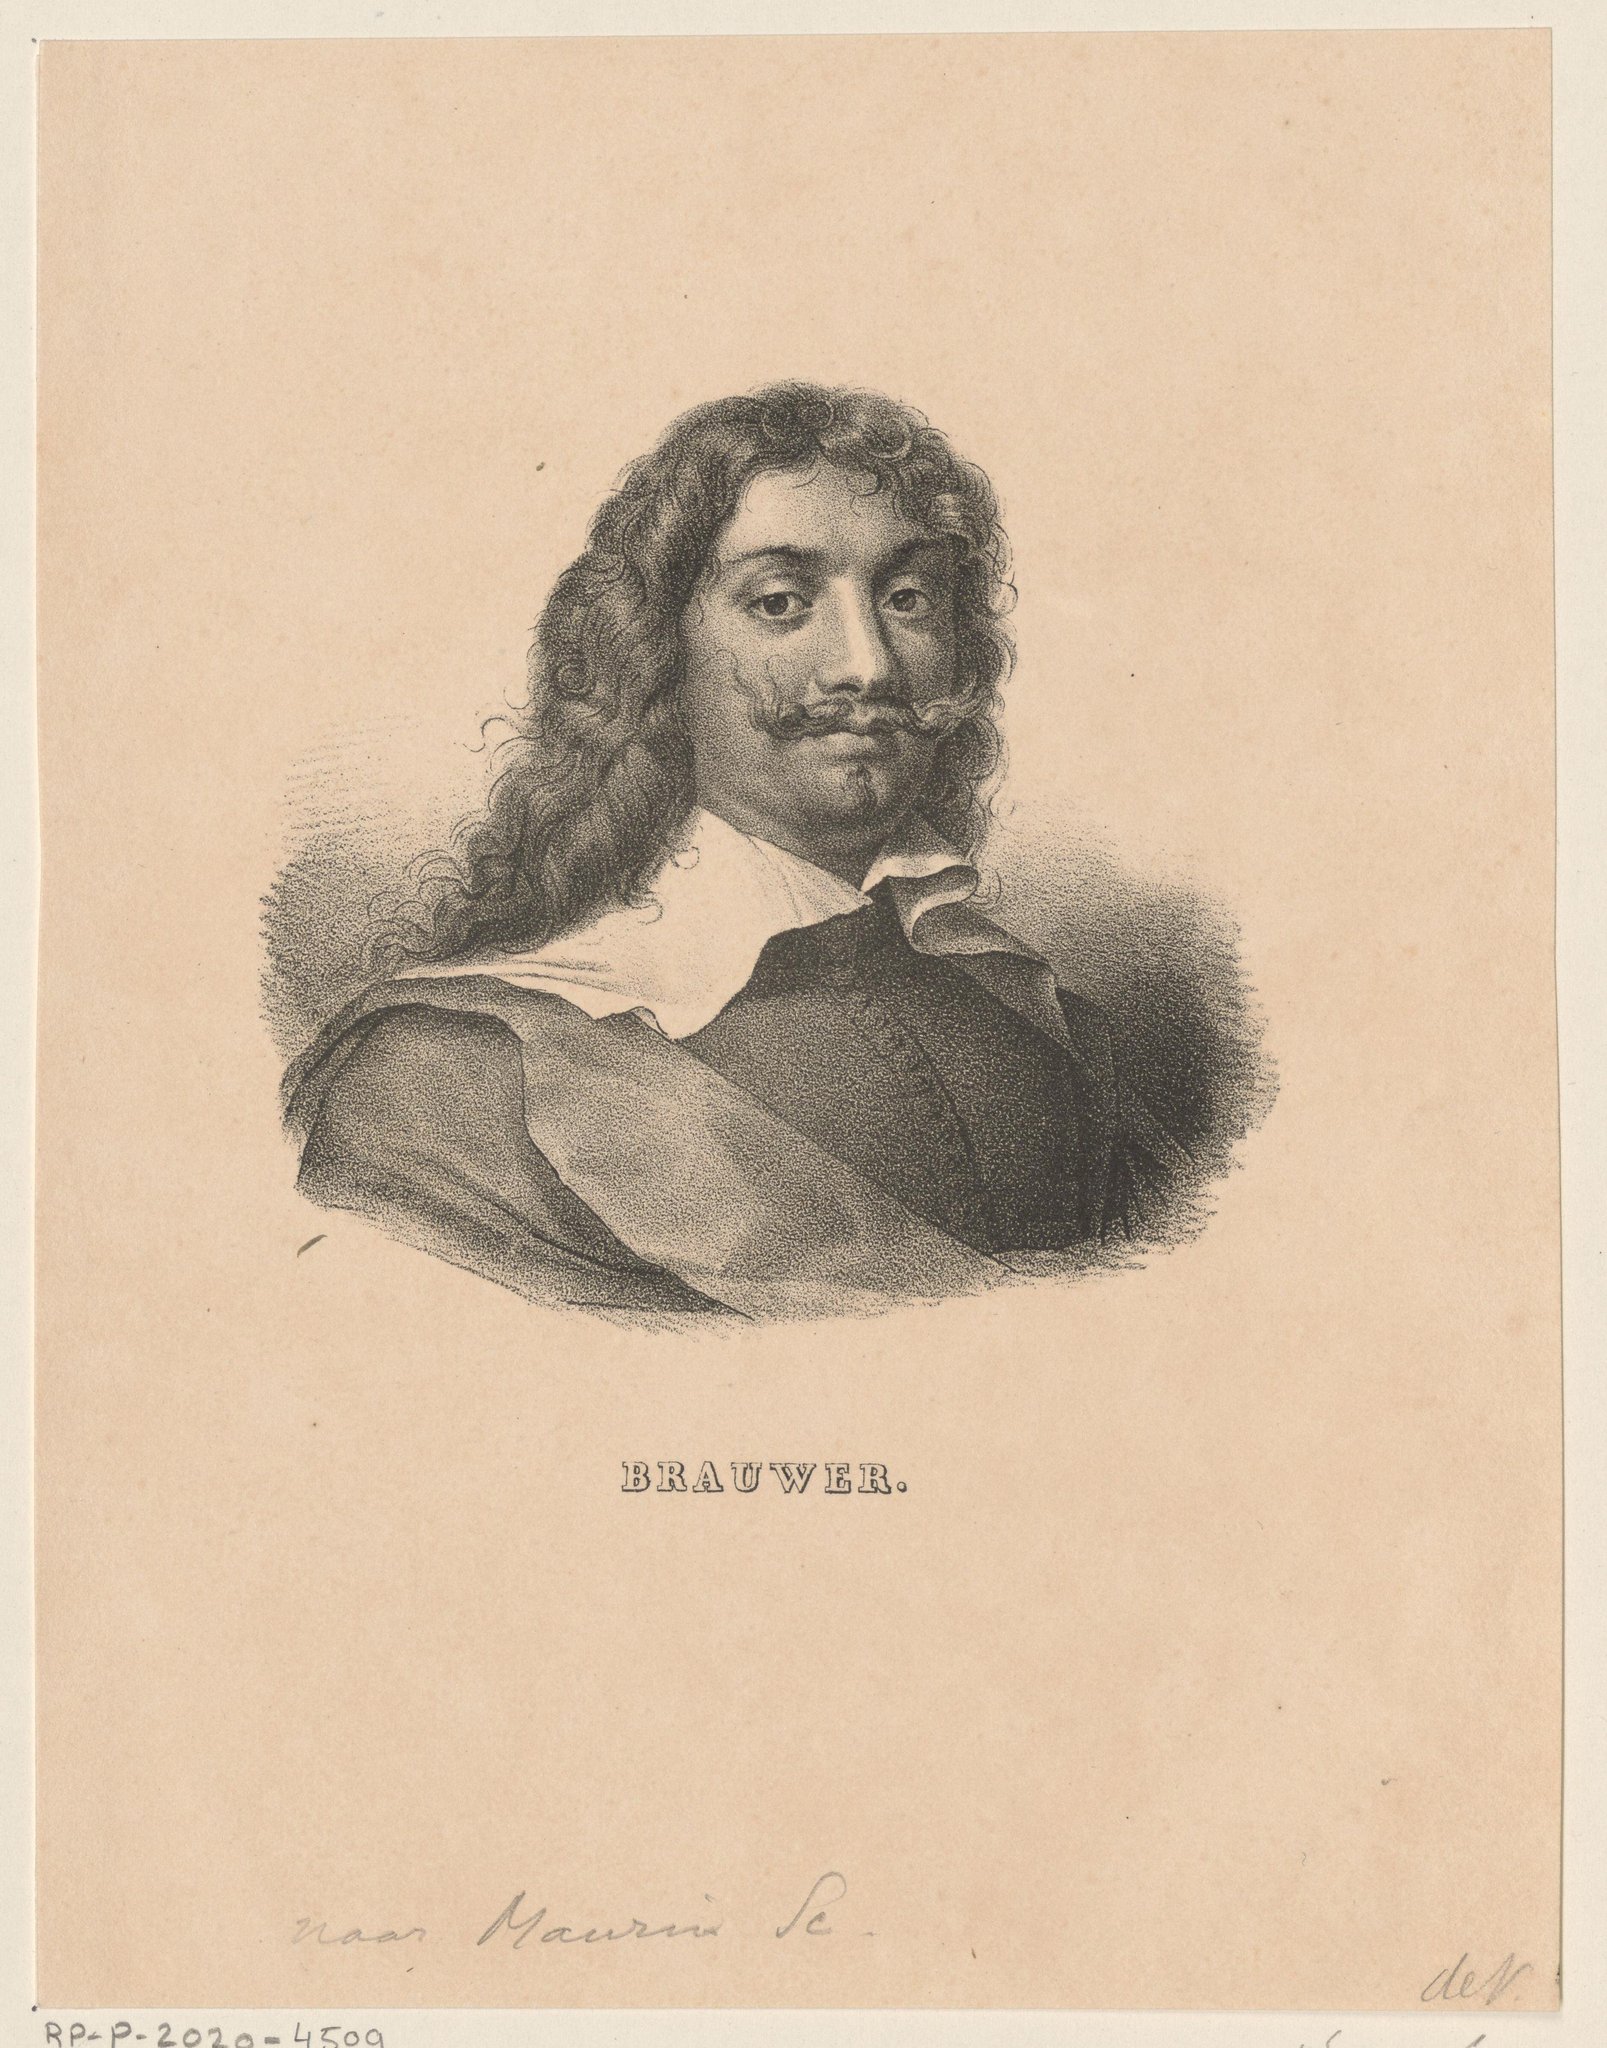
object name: print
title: Portret van Adriaen Brouwer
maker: Anonymous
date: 1825-1874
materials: paper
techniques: lithograph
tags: antwerp, painter, print maker, draughtsman, adriaen brouwer, historical persons, portrait, self-portrait of artist